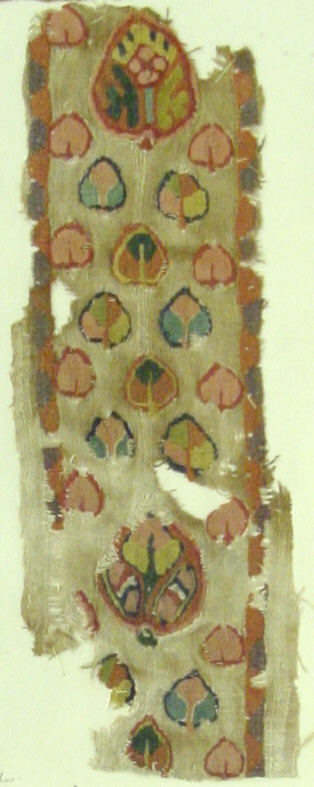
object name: textile fragment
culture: coptic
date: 401-500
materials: linen, wool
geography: egypt